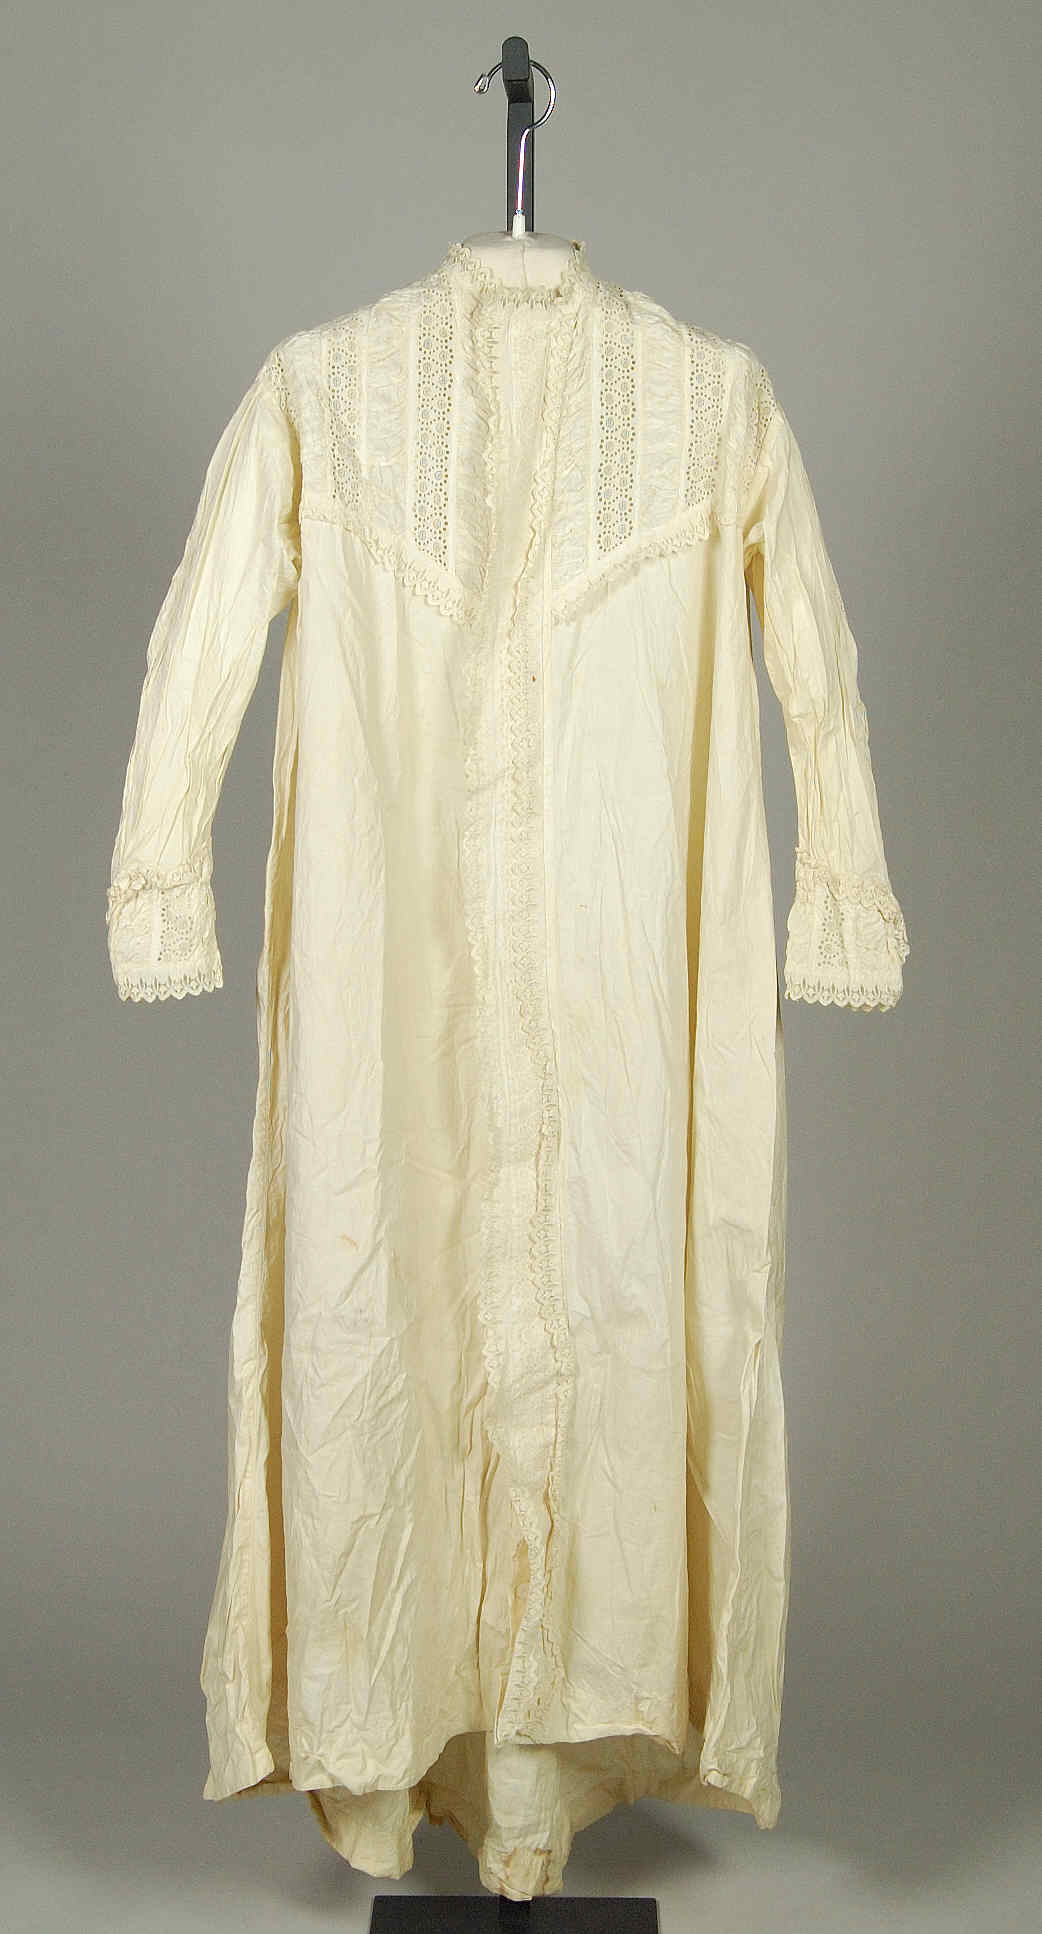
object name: lingerie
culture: american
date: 1865-1870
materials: cotton